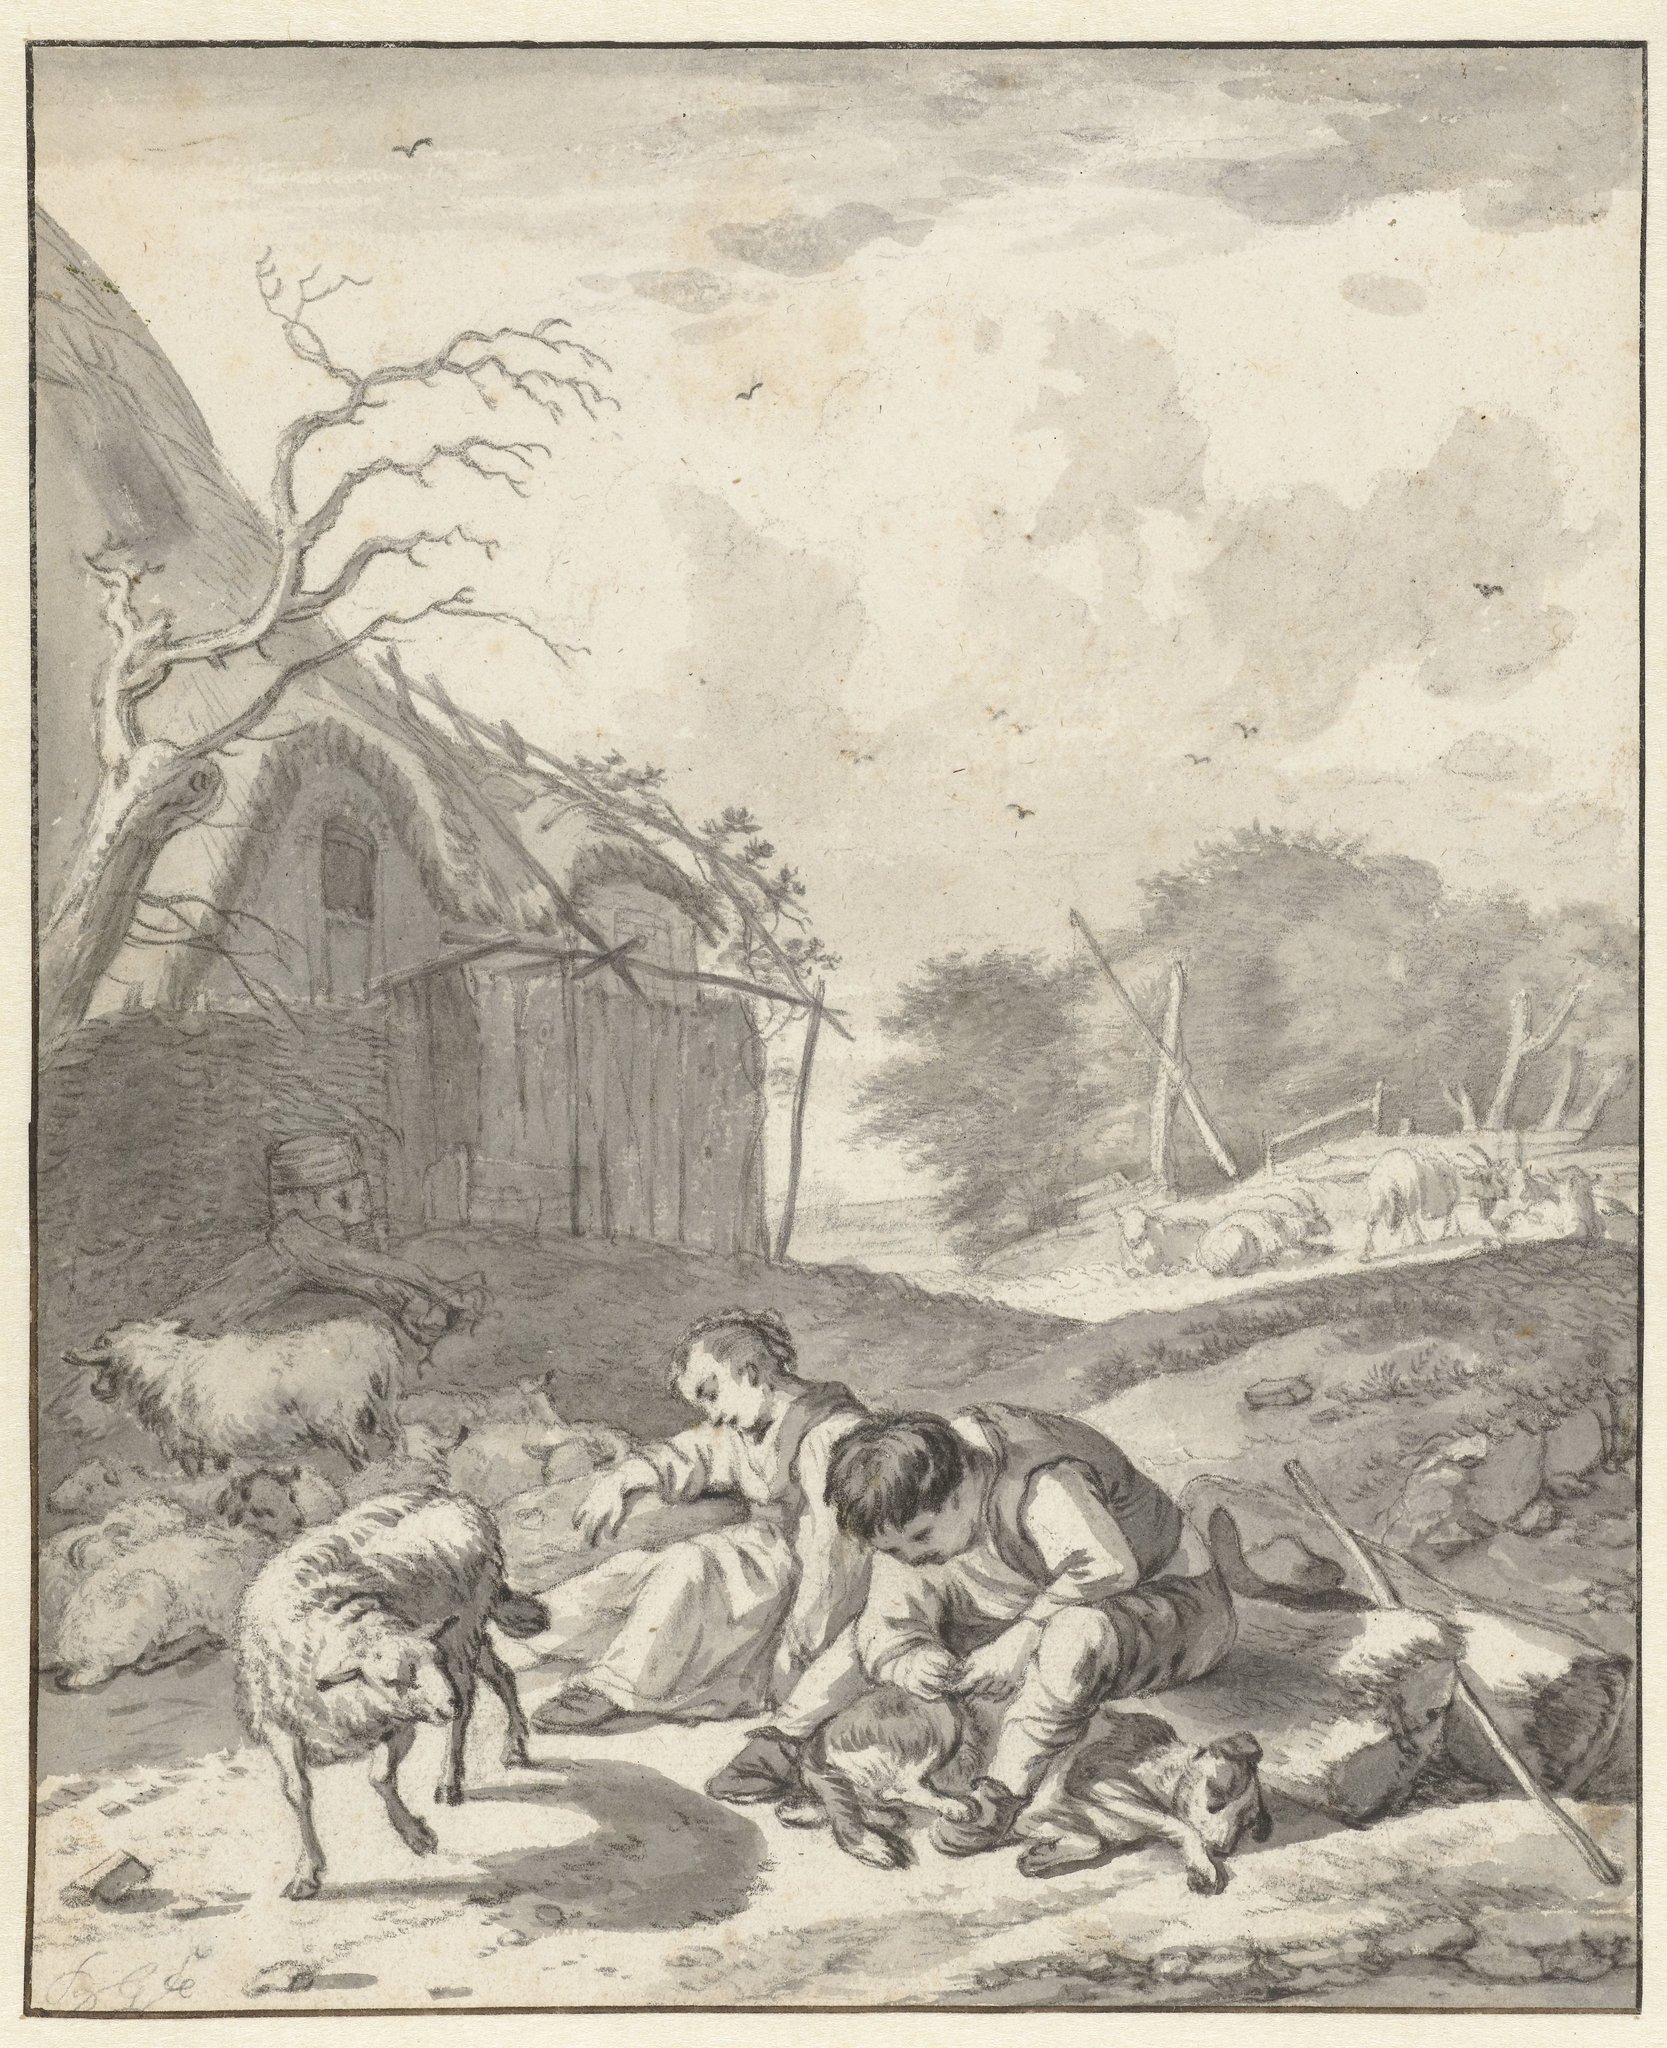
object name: drawing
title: Herder en een herderin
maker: barent gael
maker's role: draughtsman, painter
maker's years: 1630-1698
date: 1640-1673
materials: chalk, paper, pencil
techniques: brush